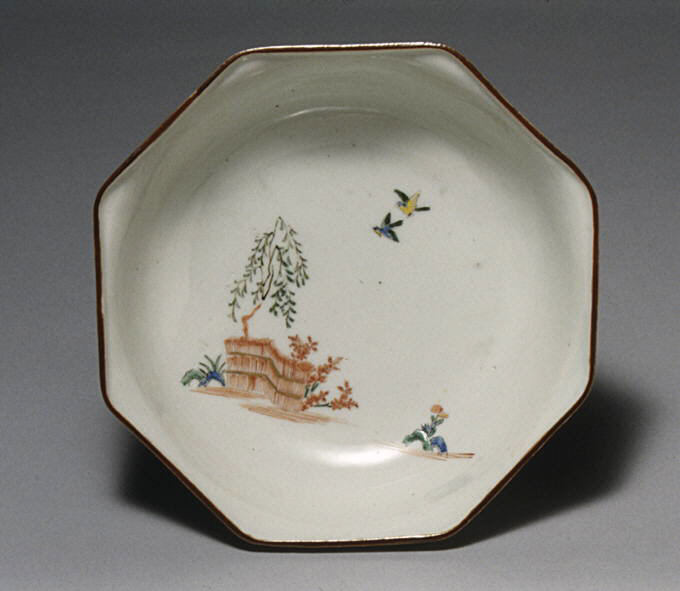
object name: bowl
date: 1690-1750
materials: hard paste porcelain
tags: birds,houses,trees